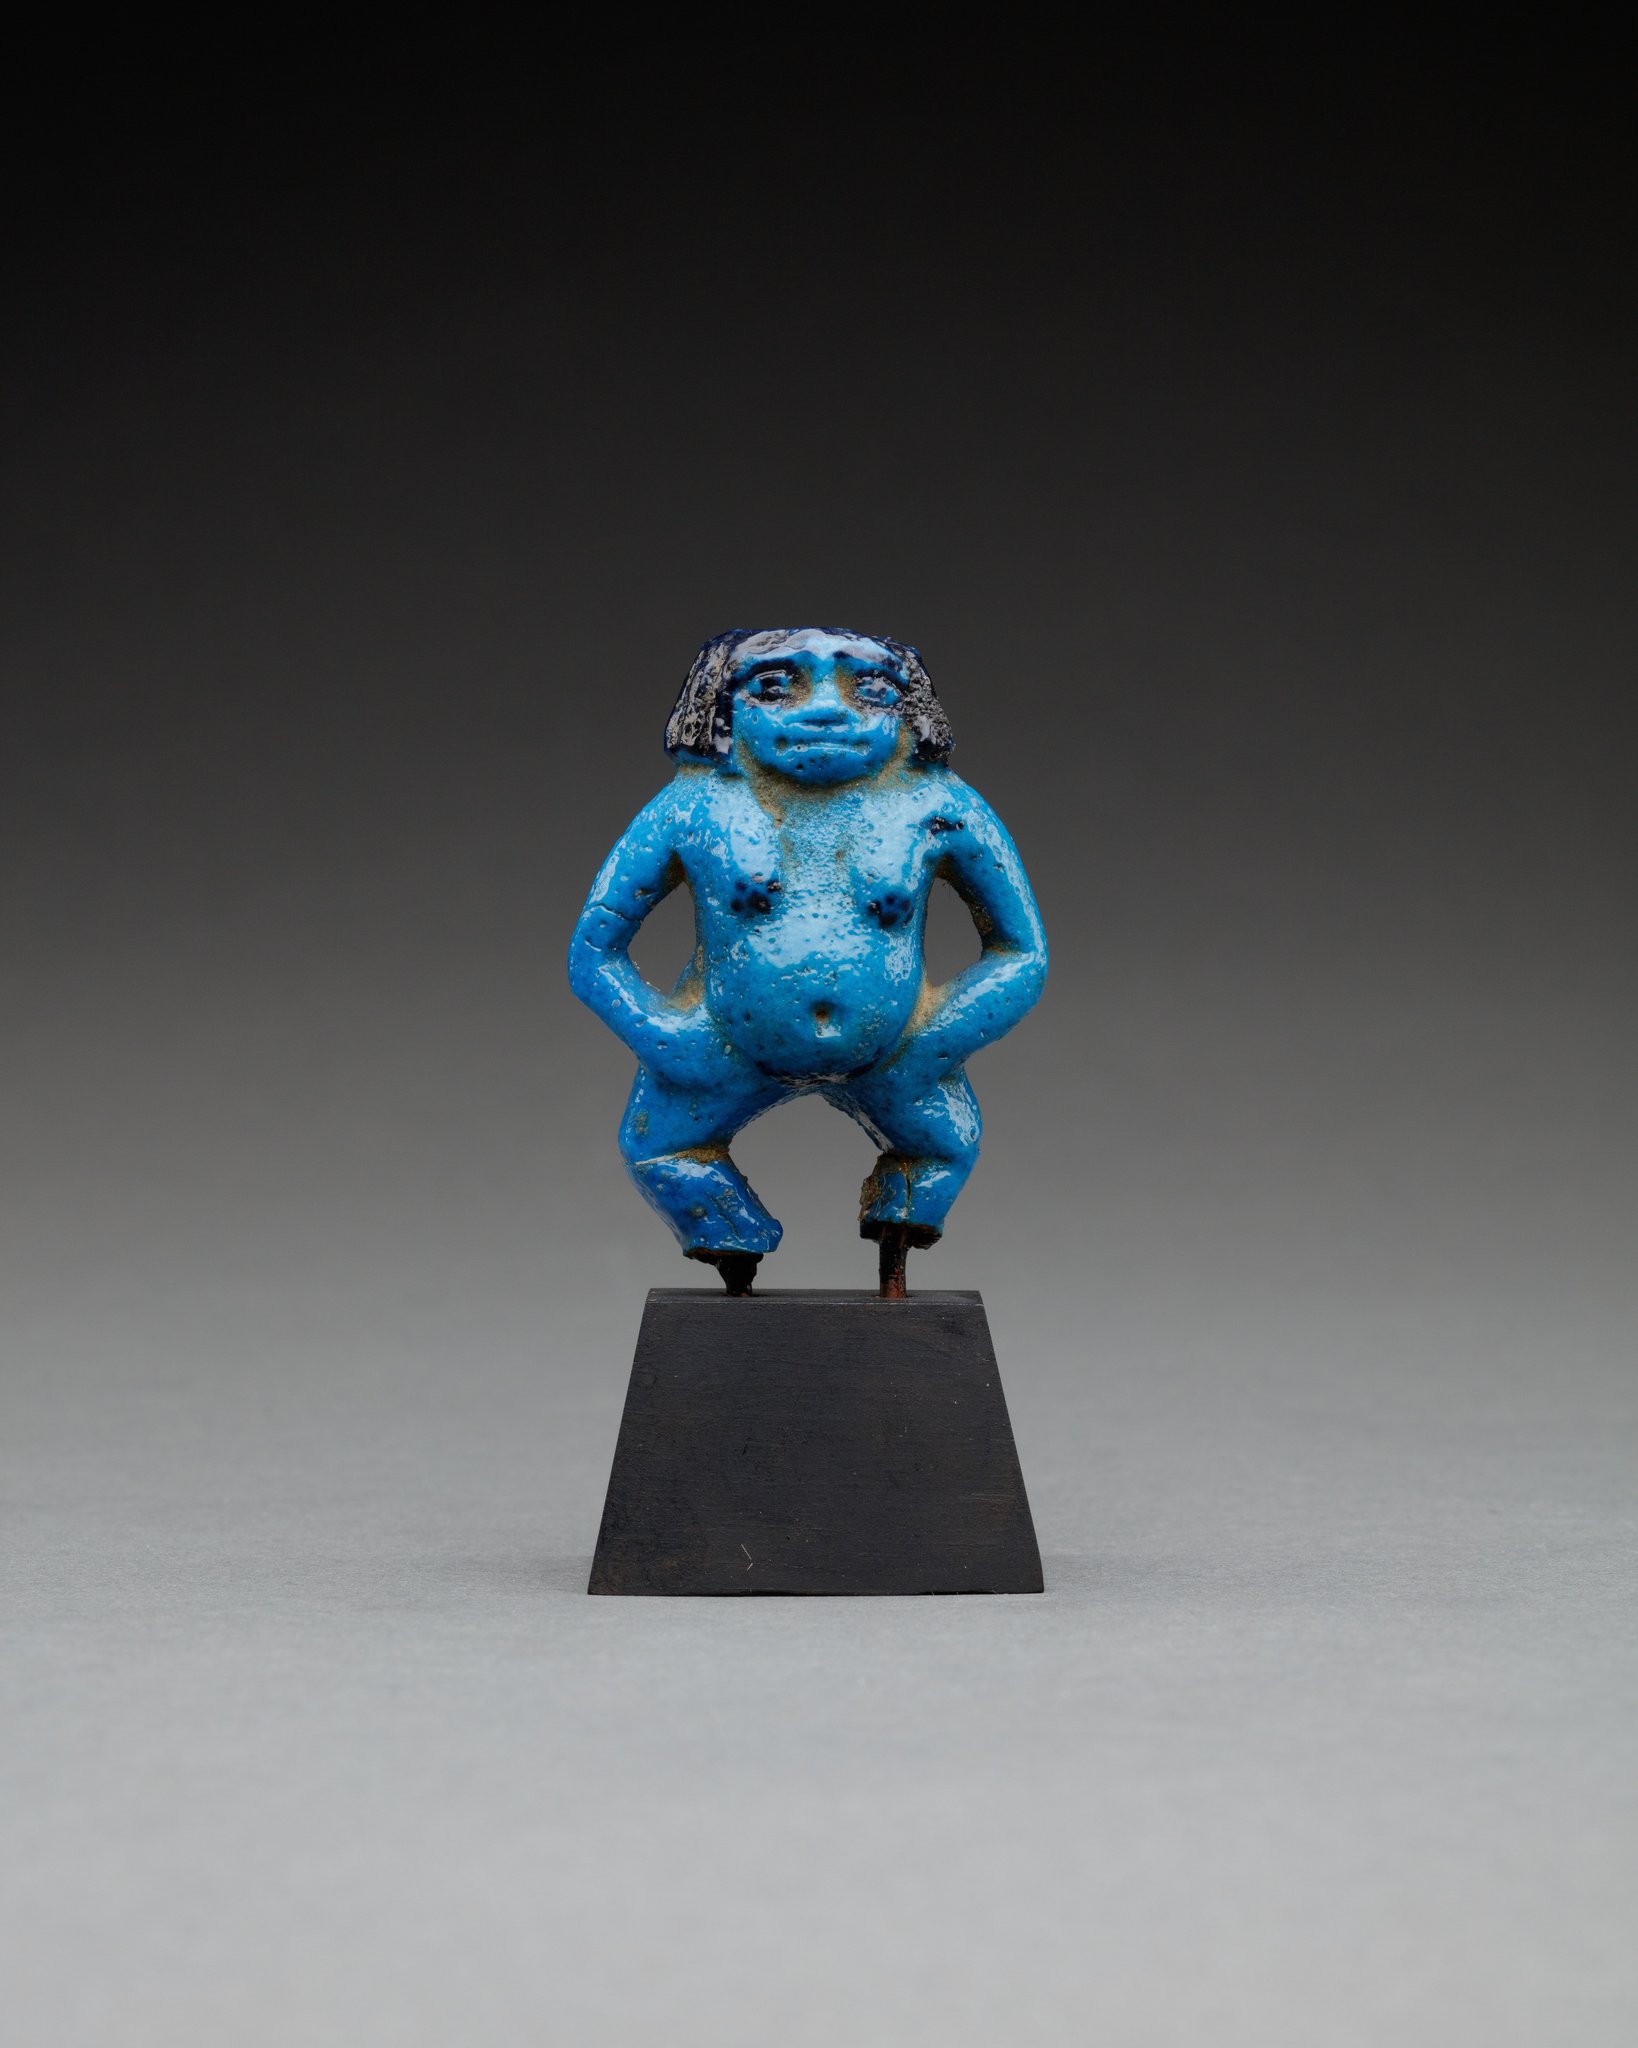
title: Container in the Form of a Female Dwarf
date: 1981-1640 BCE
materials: faience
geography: egypt